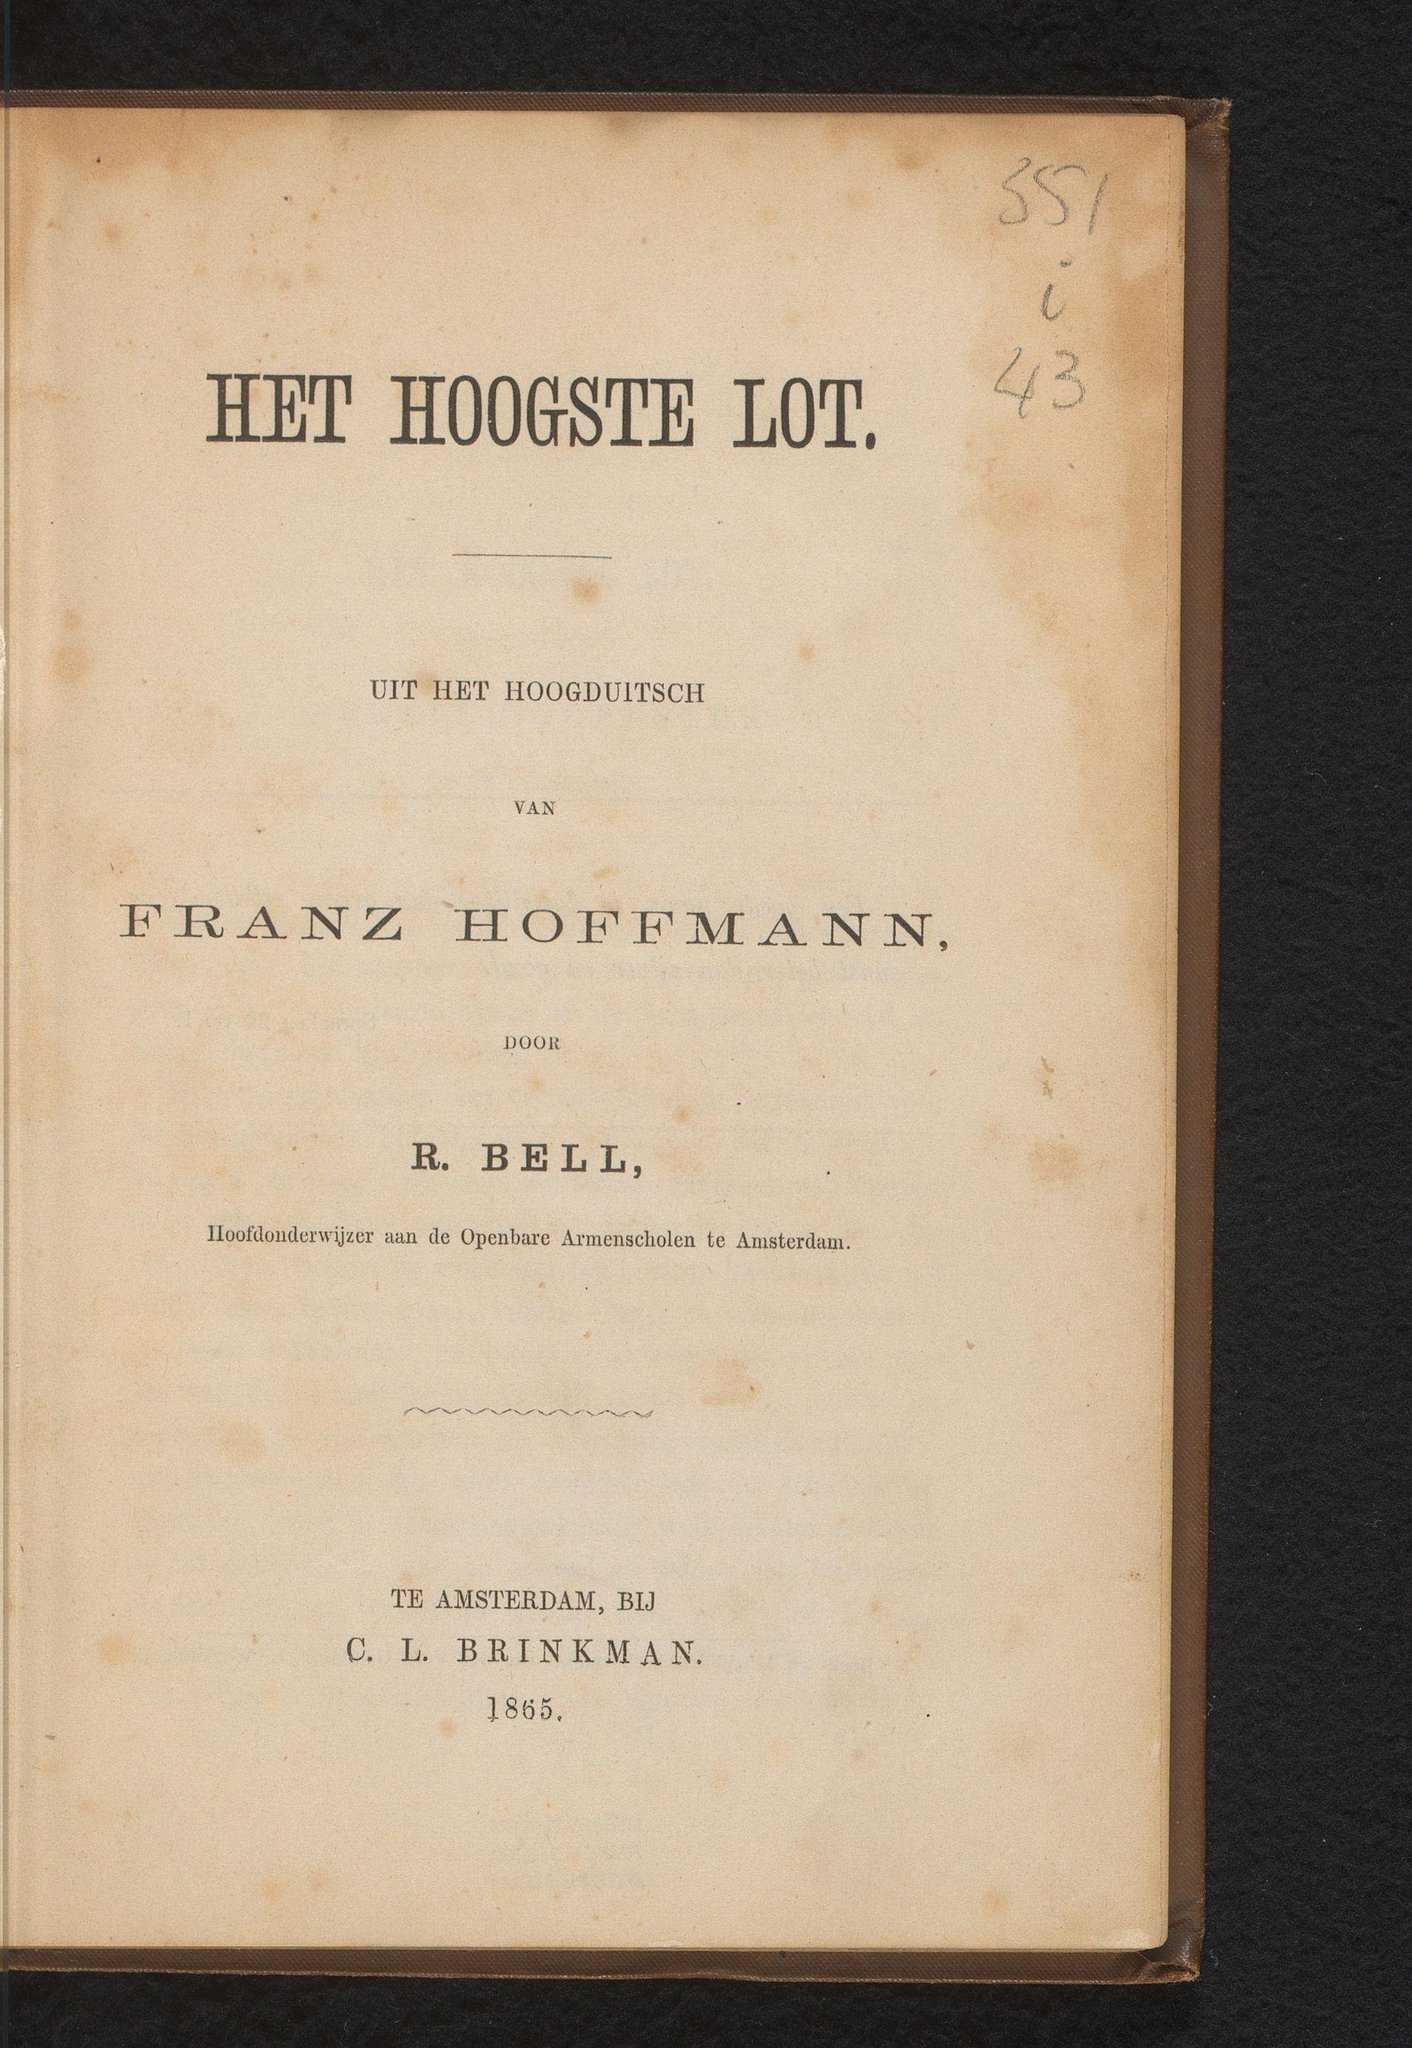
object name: book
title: Het hoogste lot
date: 1865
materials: cardboard, paper, textile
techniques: albumen print, letterpress printing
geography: wageningen